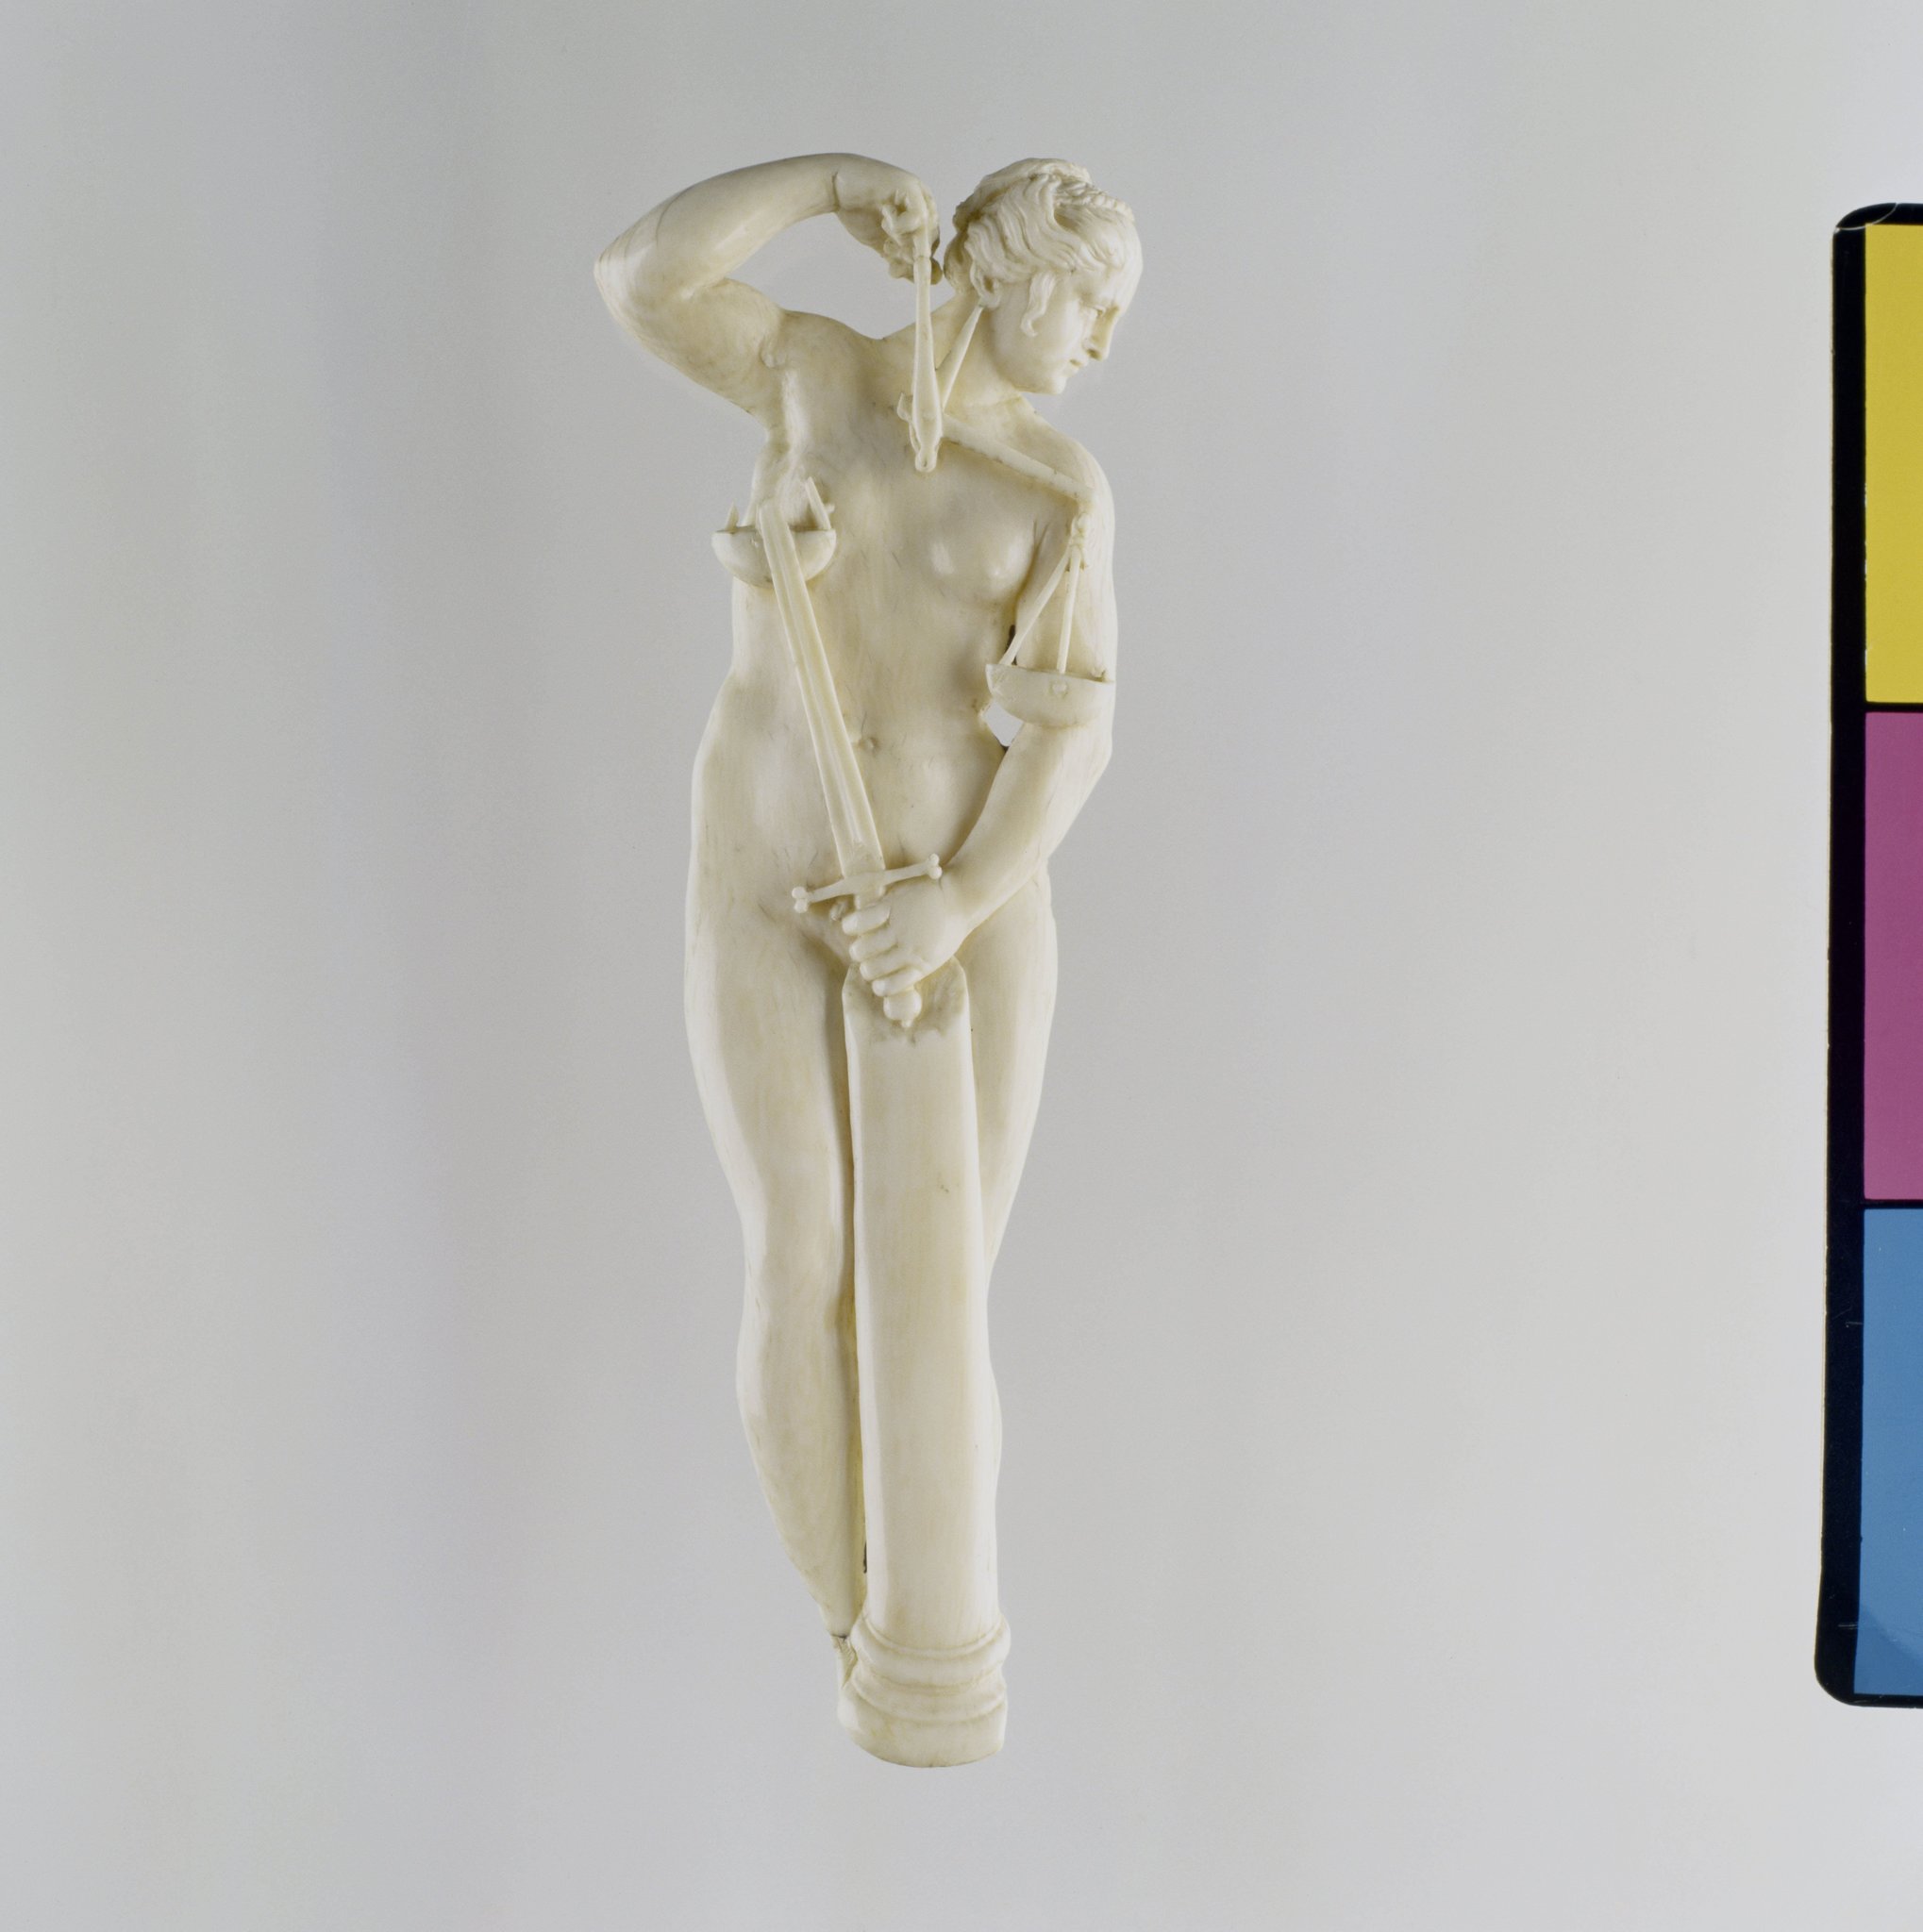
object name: figure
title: Justitia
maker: Anonymous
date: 1600-1625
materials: ivory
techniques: cutting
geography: southern germany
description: Temperance and Justice. Ivory. Southern Germany, c. 1600-1650. The figure of Temperance was taken from an engraving by Hendrick Goltzius (1558-1617). Justice is based on her: although reversed, the contour is virtually identical. Probably the figures were originally applied to a cabinet. Justice: gift of J. Holstein, 1994.